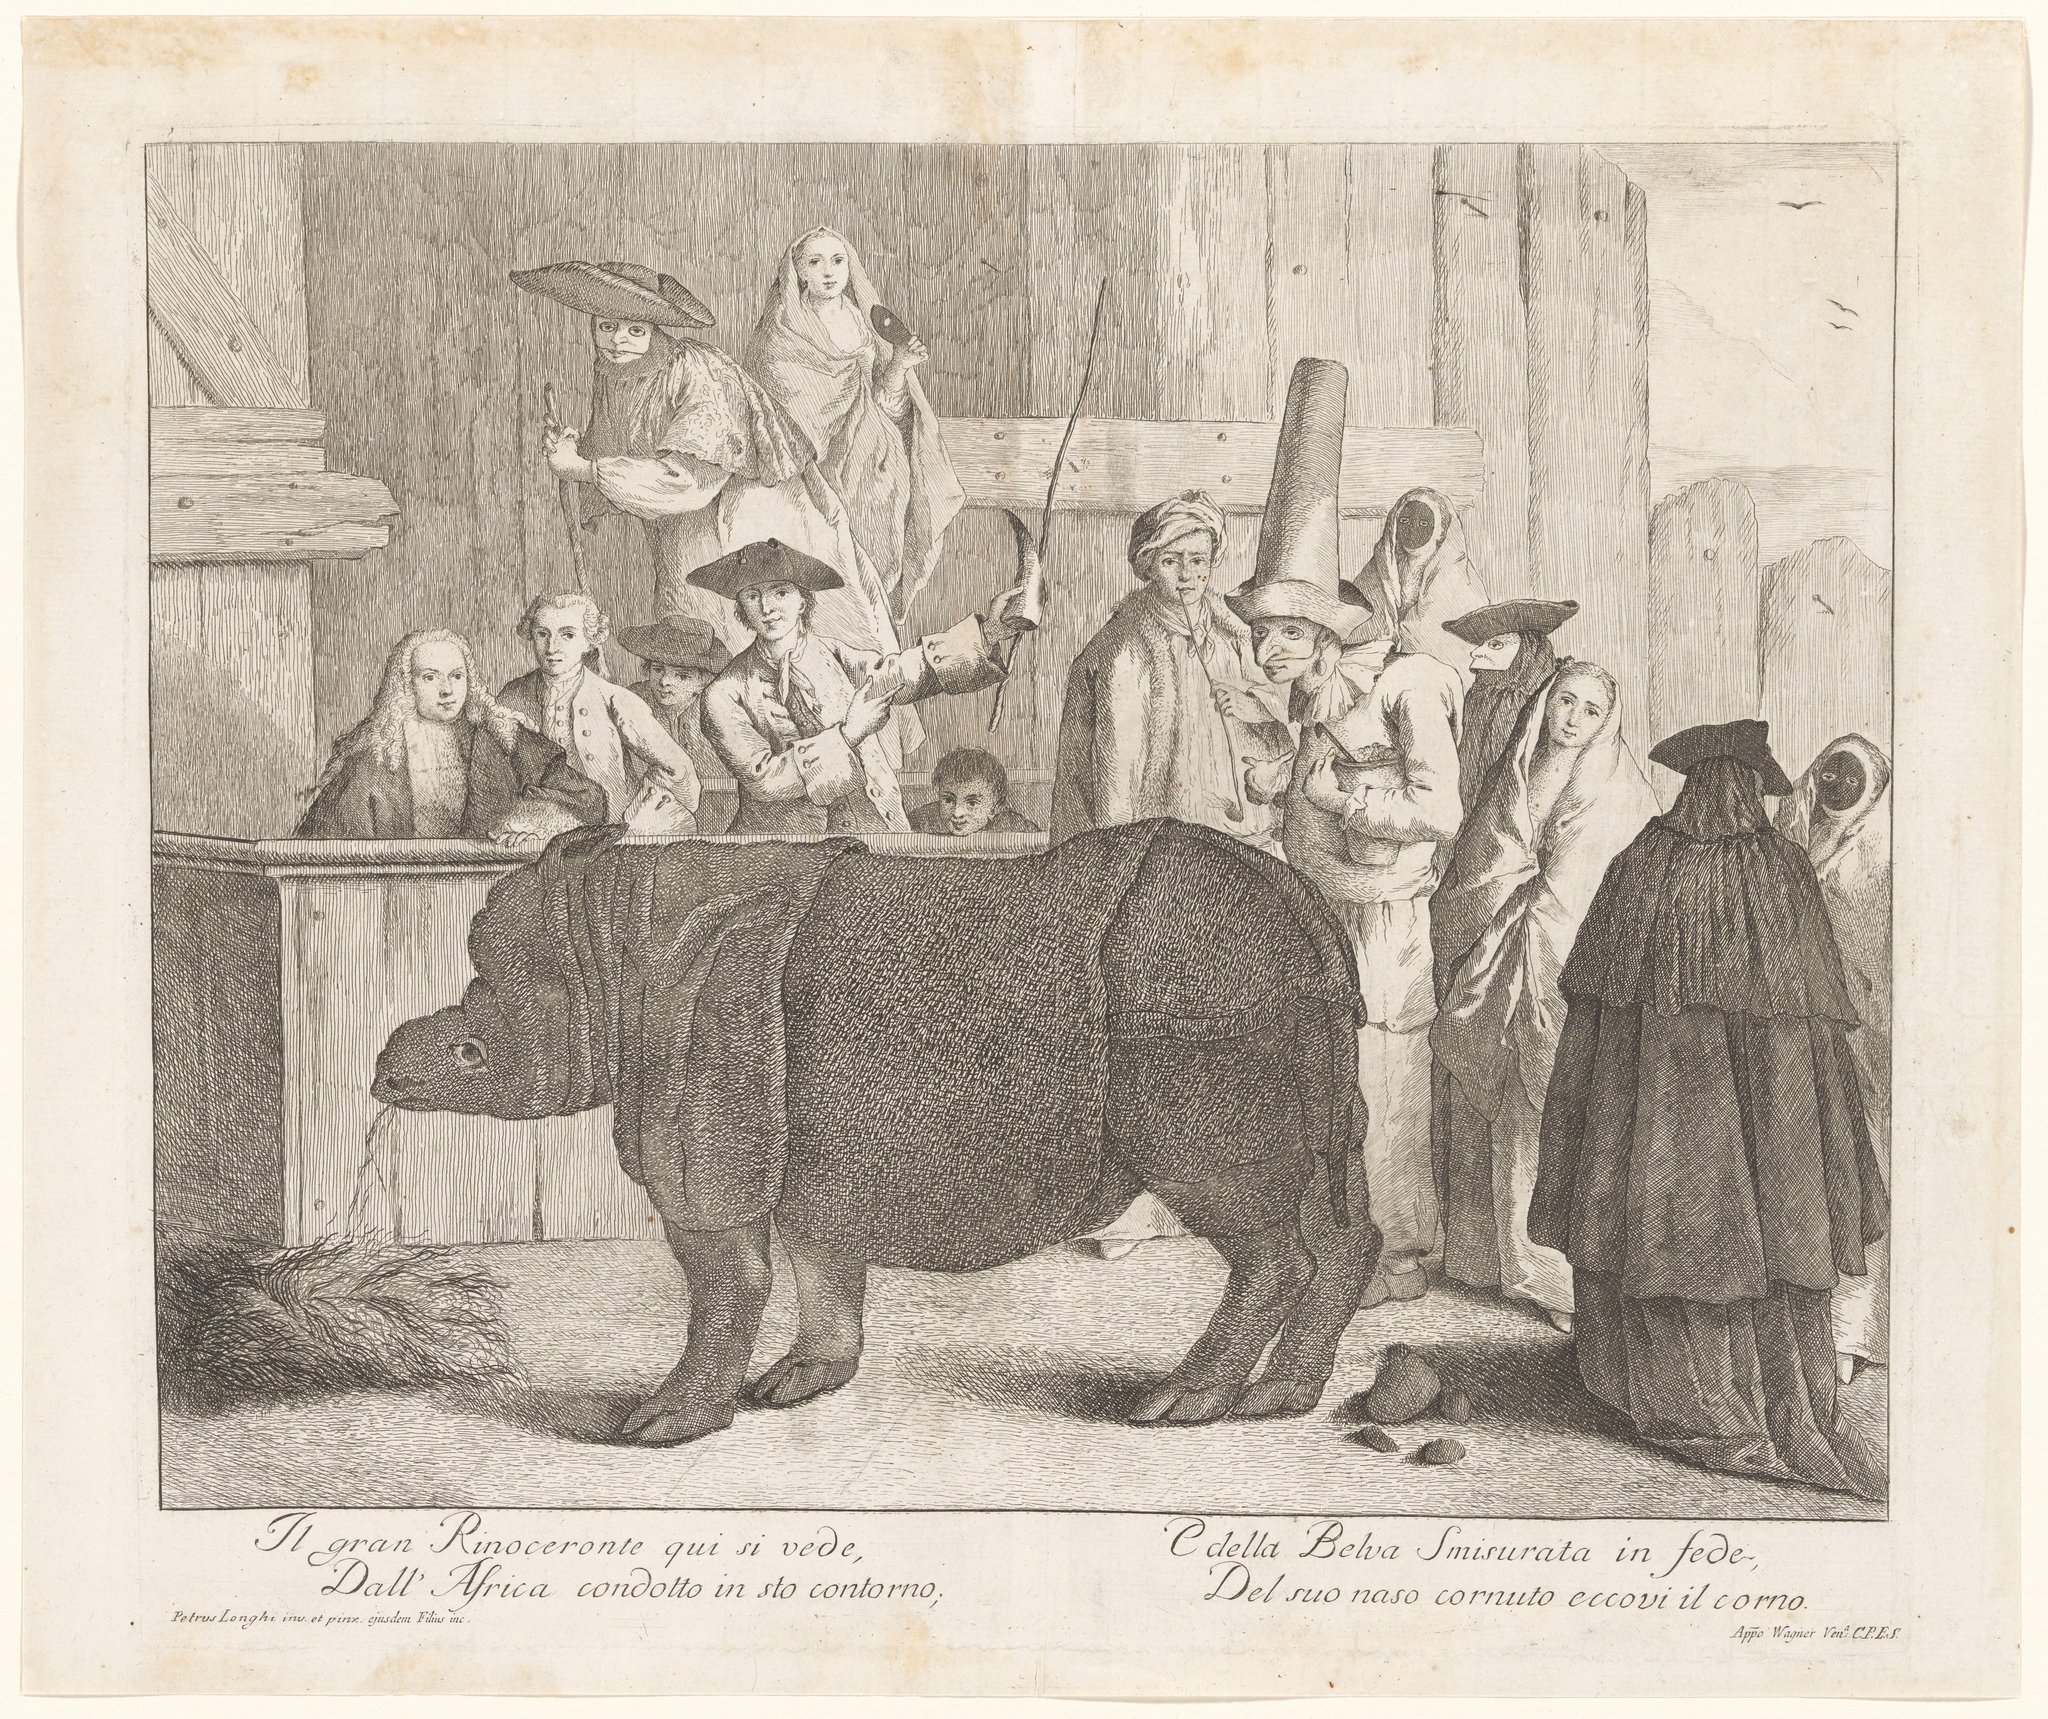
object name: print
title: Clara in Venice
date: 1751-1755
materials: paper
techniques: etching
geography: venice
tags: london, circus animals, hoofed animals: rhinoceros, carnival, shrovetide (non-liturgical celebration), venice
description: Alessandro Longhi uses his father’s paintings – albeit less aptly – for an etching of Clara’s visit. In the print, too, Clara is munching hay, has defecated, is being gaped at by the audience and her horn is held up. Sometimes so many people come to see Clara that he becomes restless, and therefore dangerous. The caption mistakenly notes that Clara hails from Africa instead of South Asia.